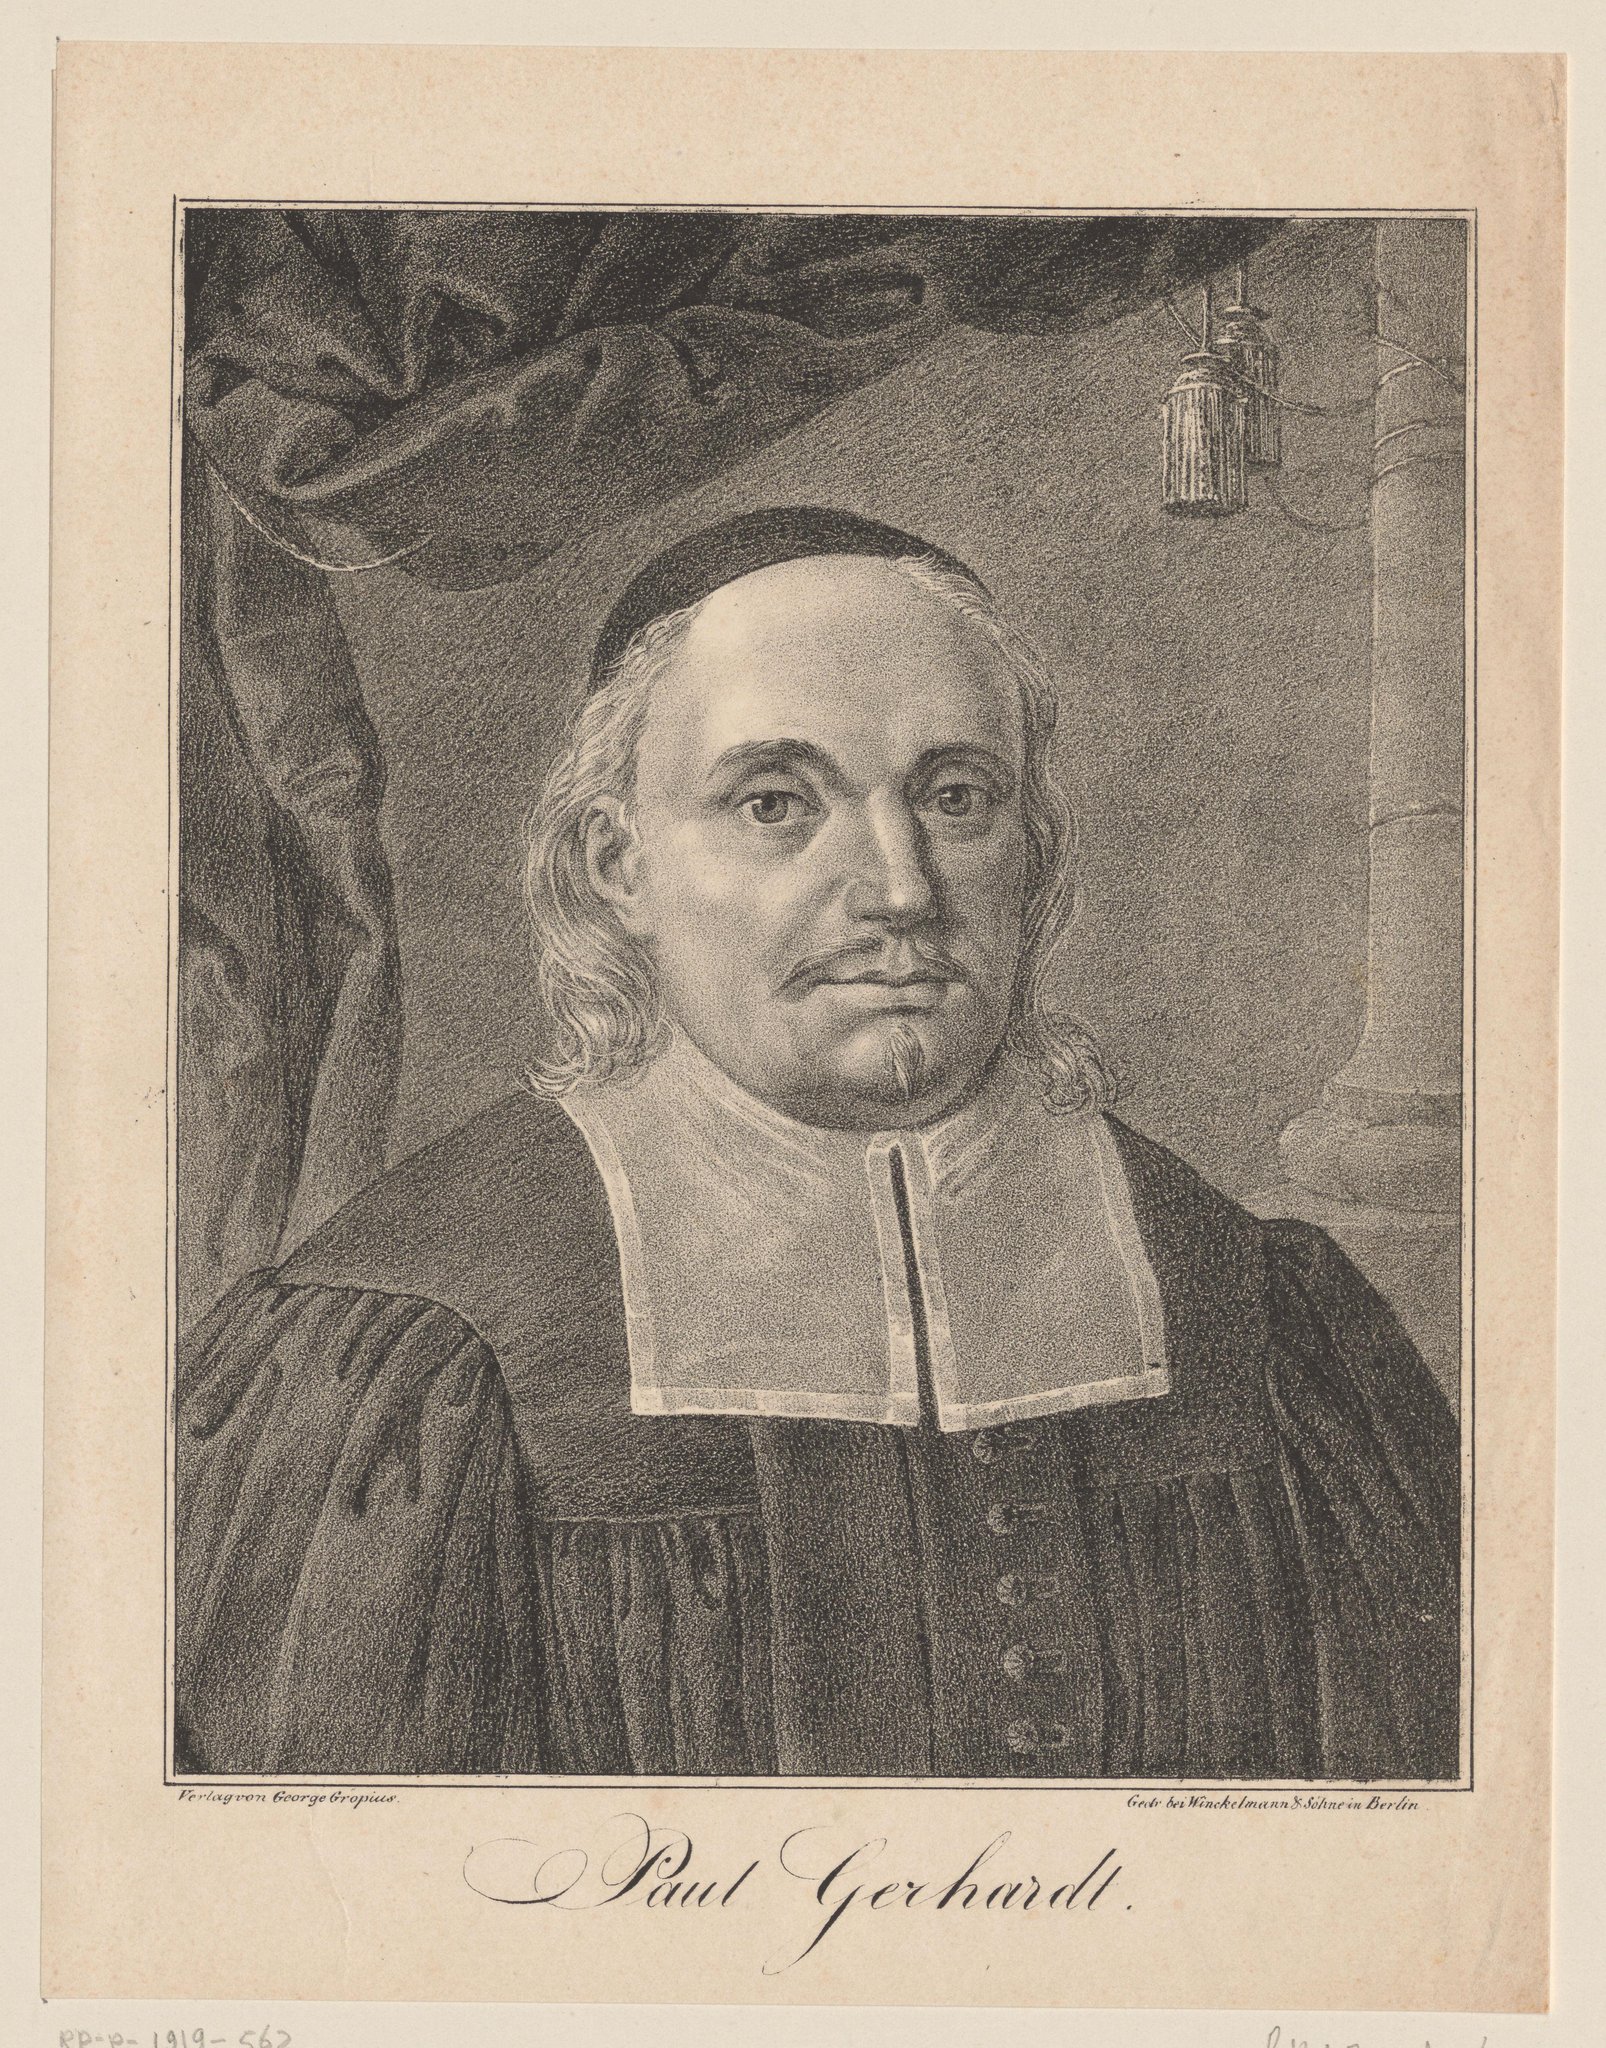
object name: print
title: Portret van Paul Gerhardt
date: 1830-1842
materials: paper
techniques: lithograph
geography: berlin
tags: historical persons, writer, poet, author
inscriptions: collector's mark: Lugt 2228